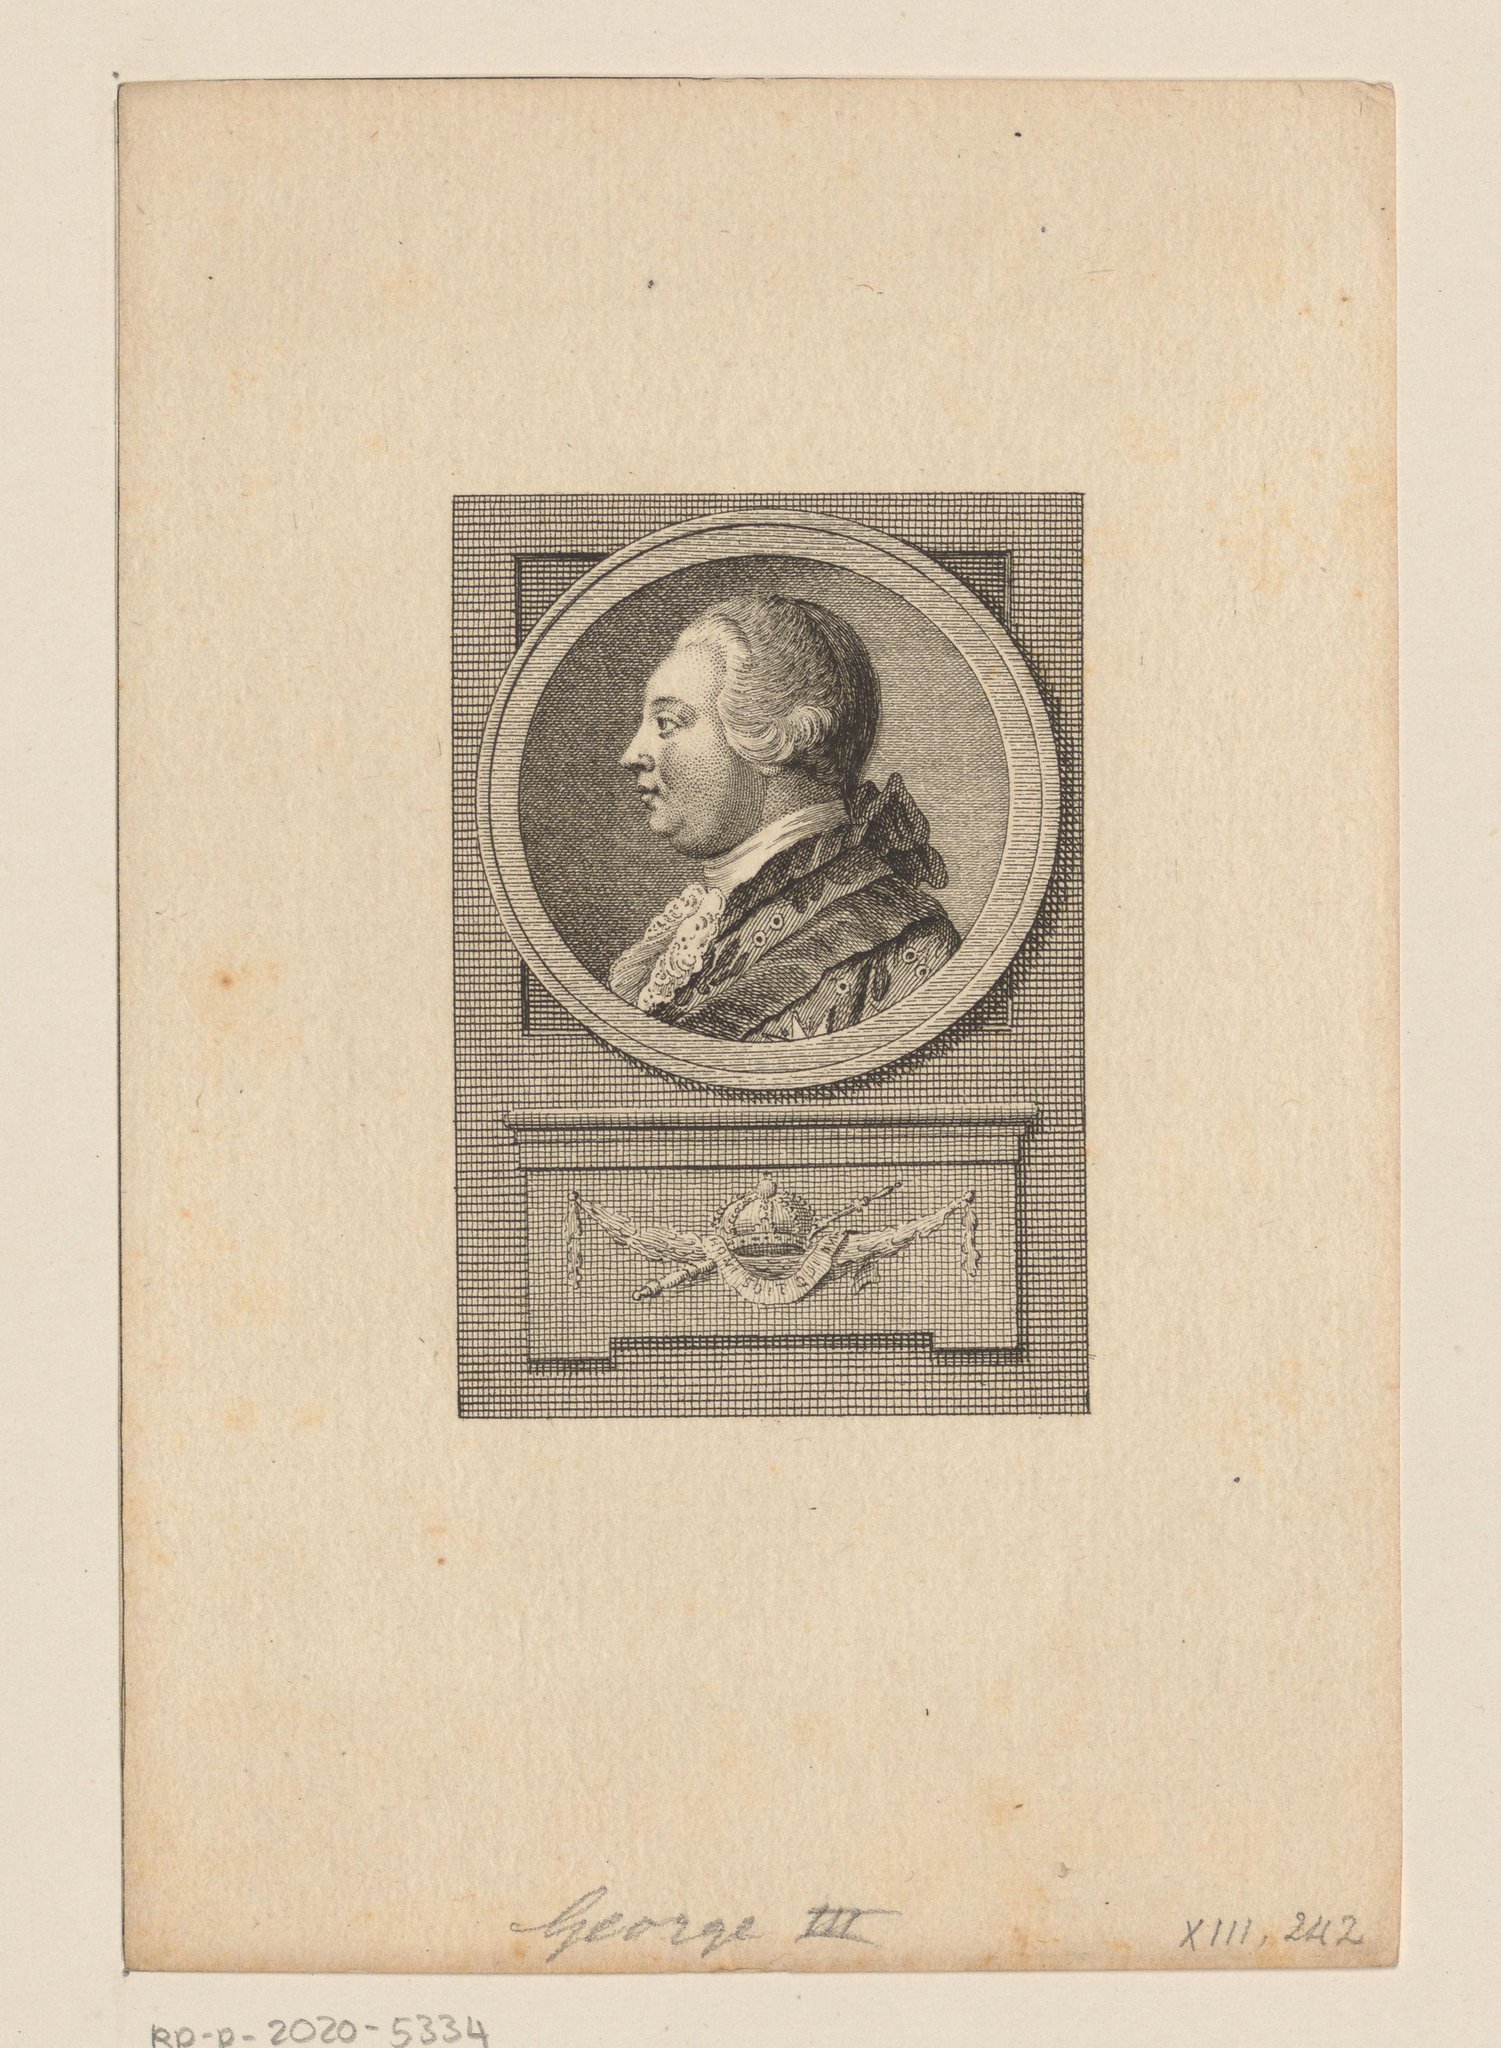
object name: print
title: Portret van George III, koning van het Verenigd Koninkrijk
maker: Anonymous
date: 1760-1820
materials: paper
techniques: engraving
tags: george iii (koning van het verenigd koninkrijk), historical persons, king